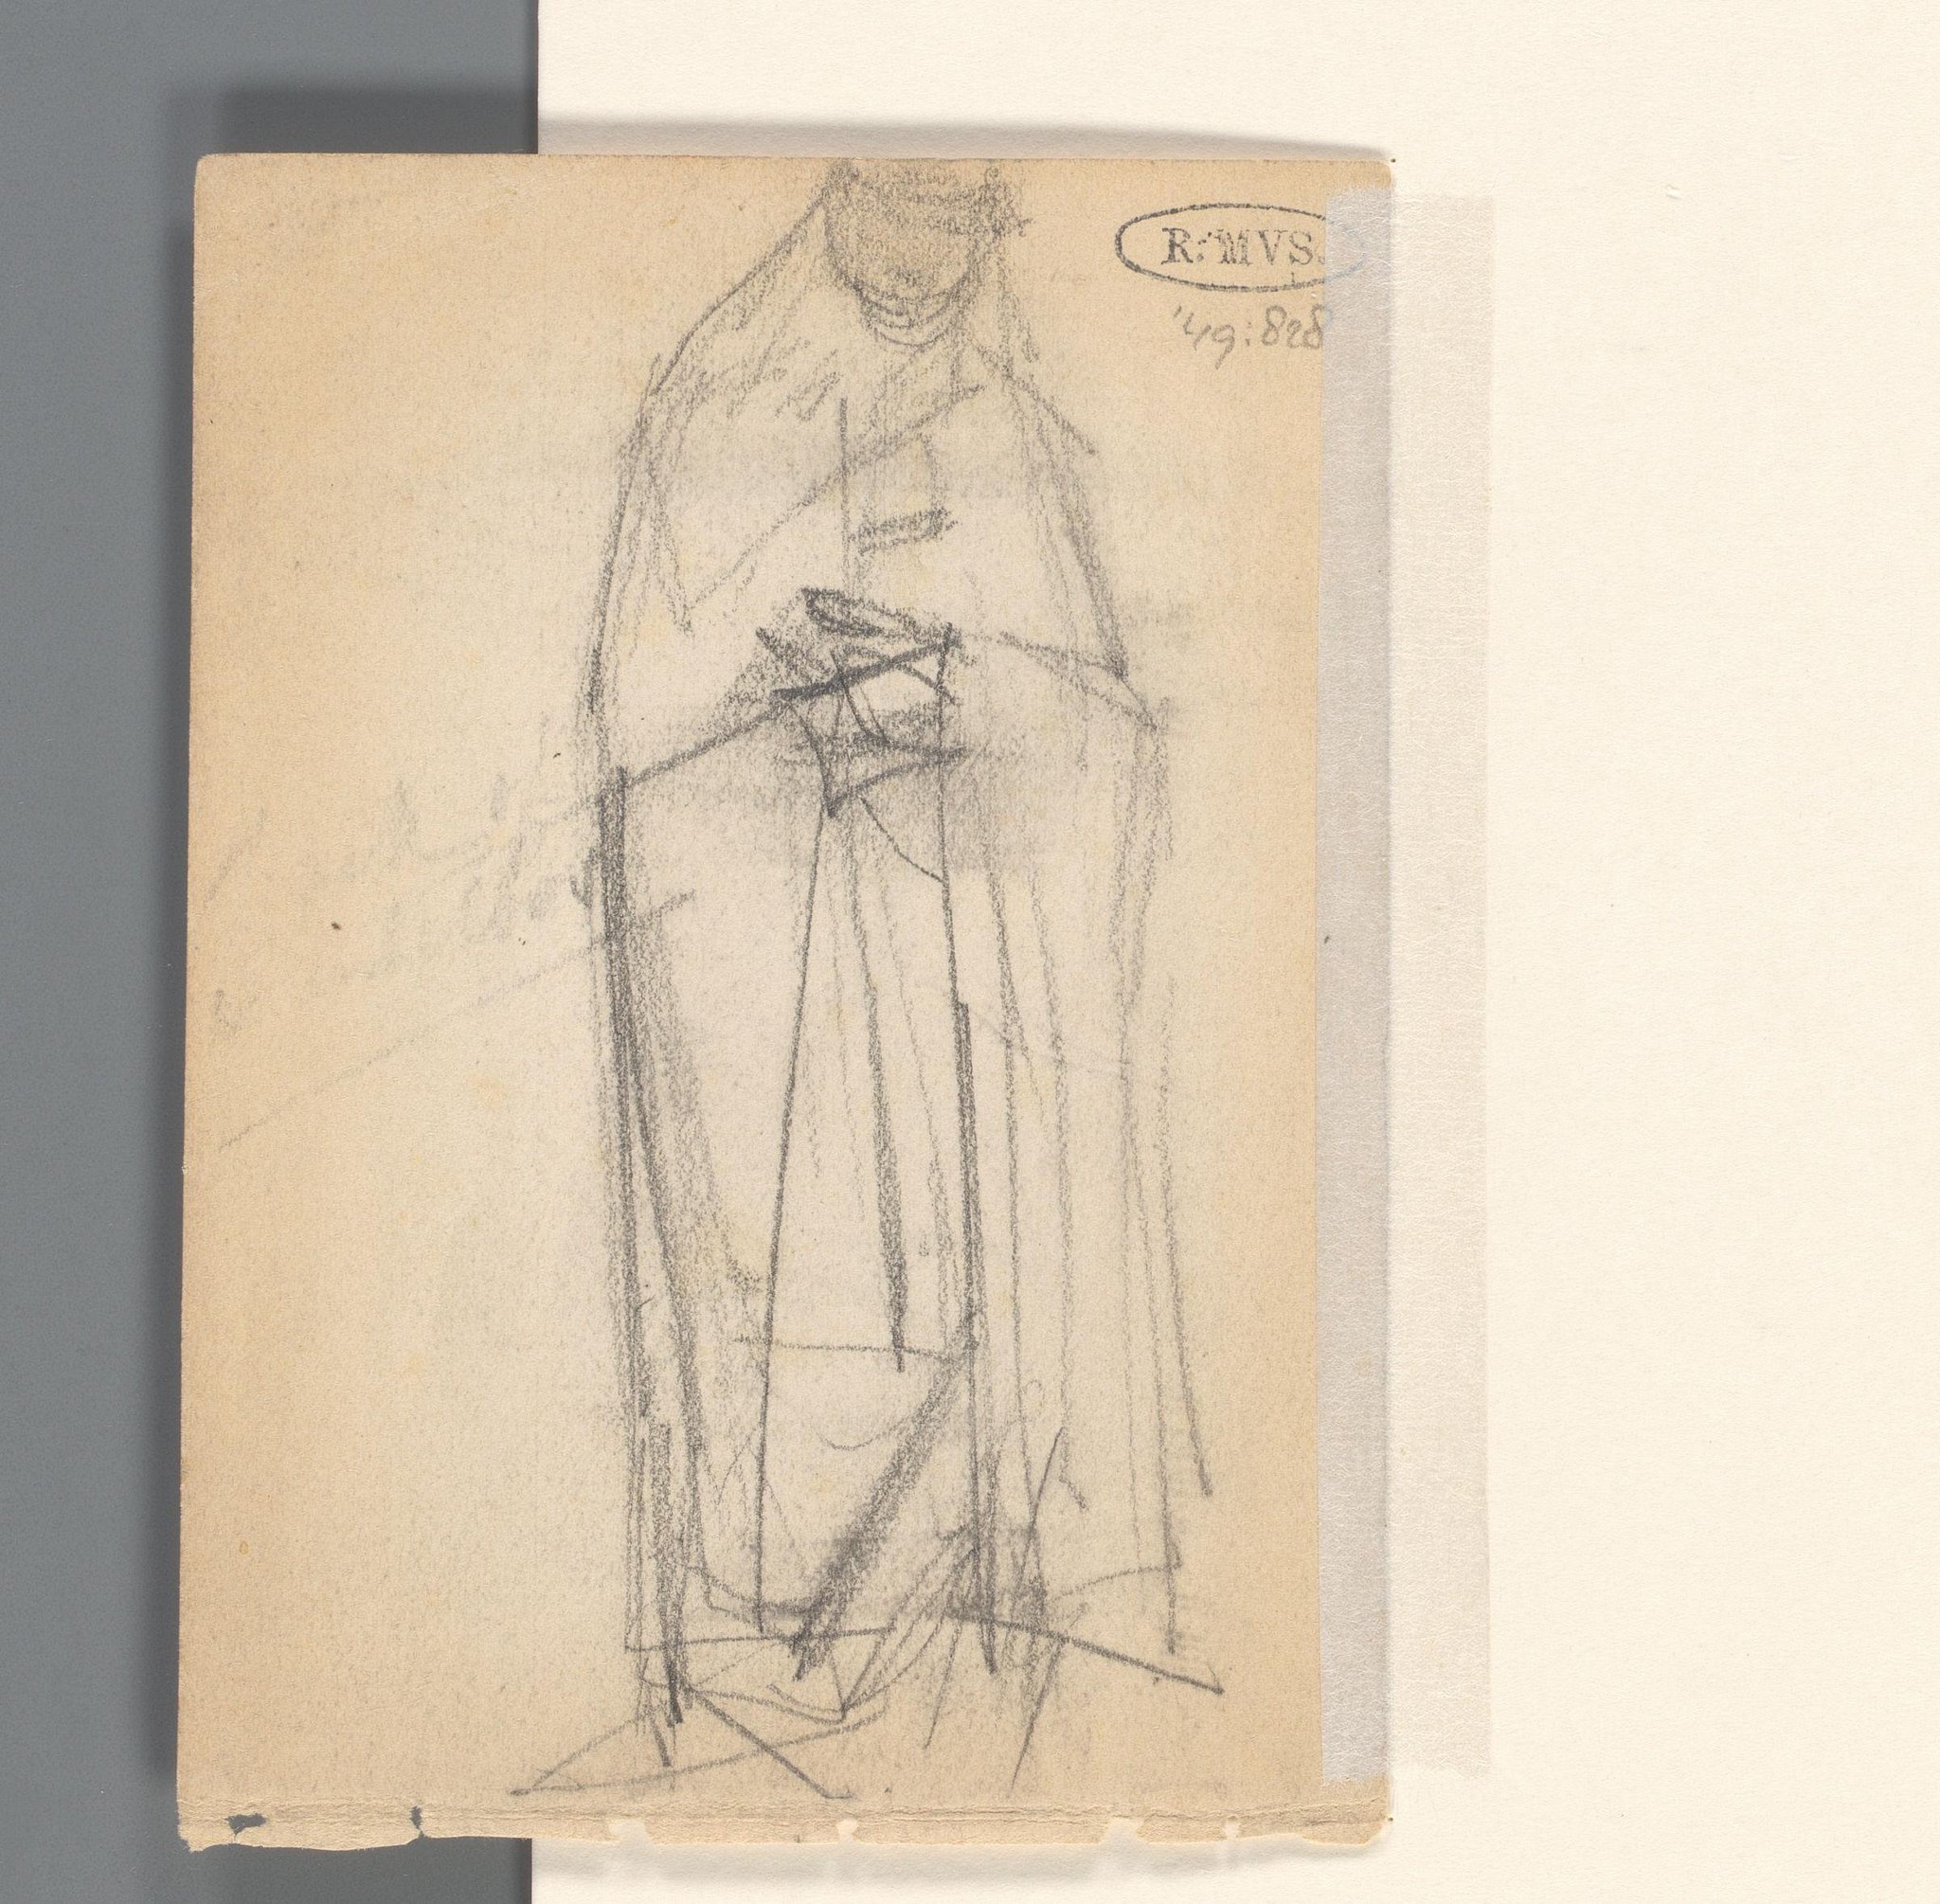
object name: drawing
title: Schetsblad met staande figuur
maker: august allebé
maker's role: draughtsman, print maker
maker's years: 1838-1927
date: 1848-1927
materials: paper, pencil